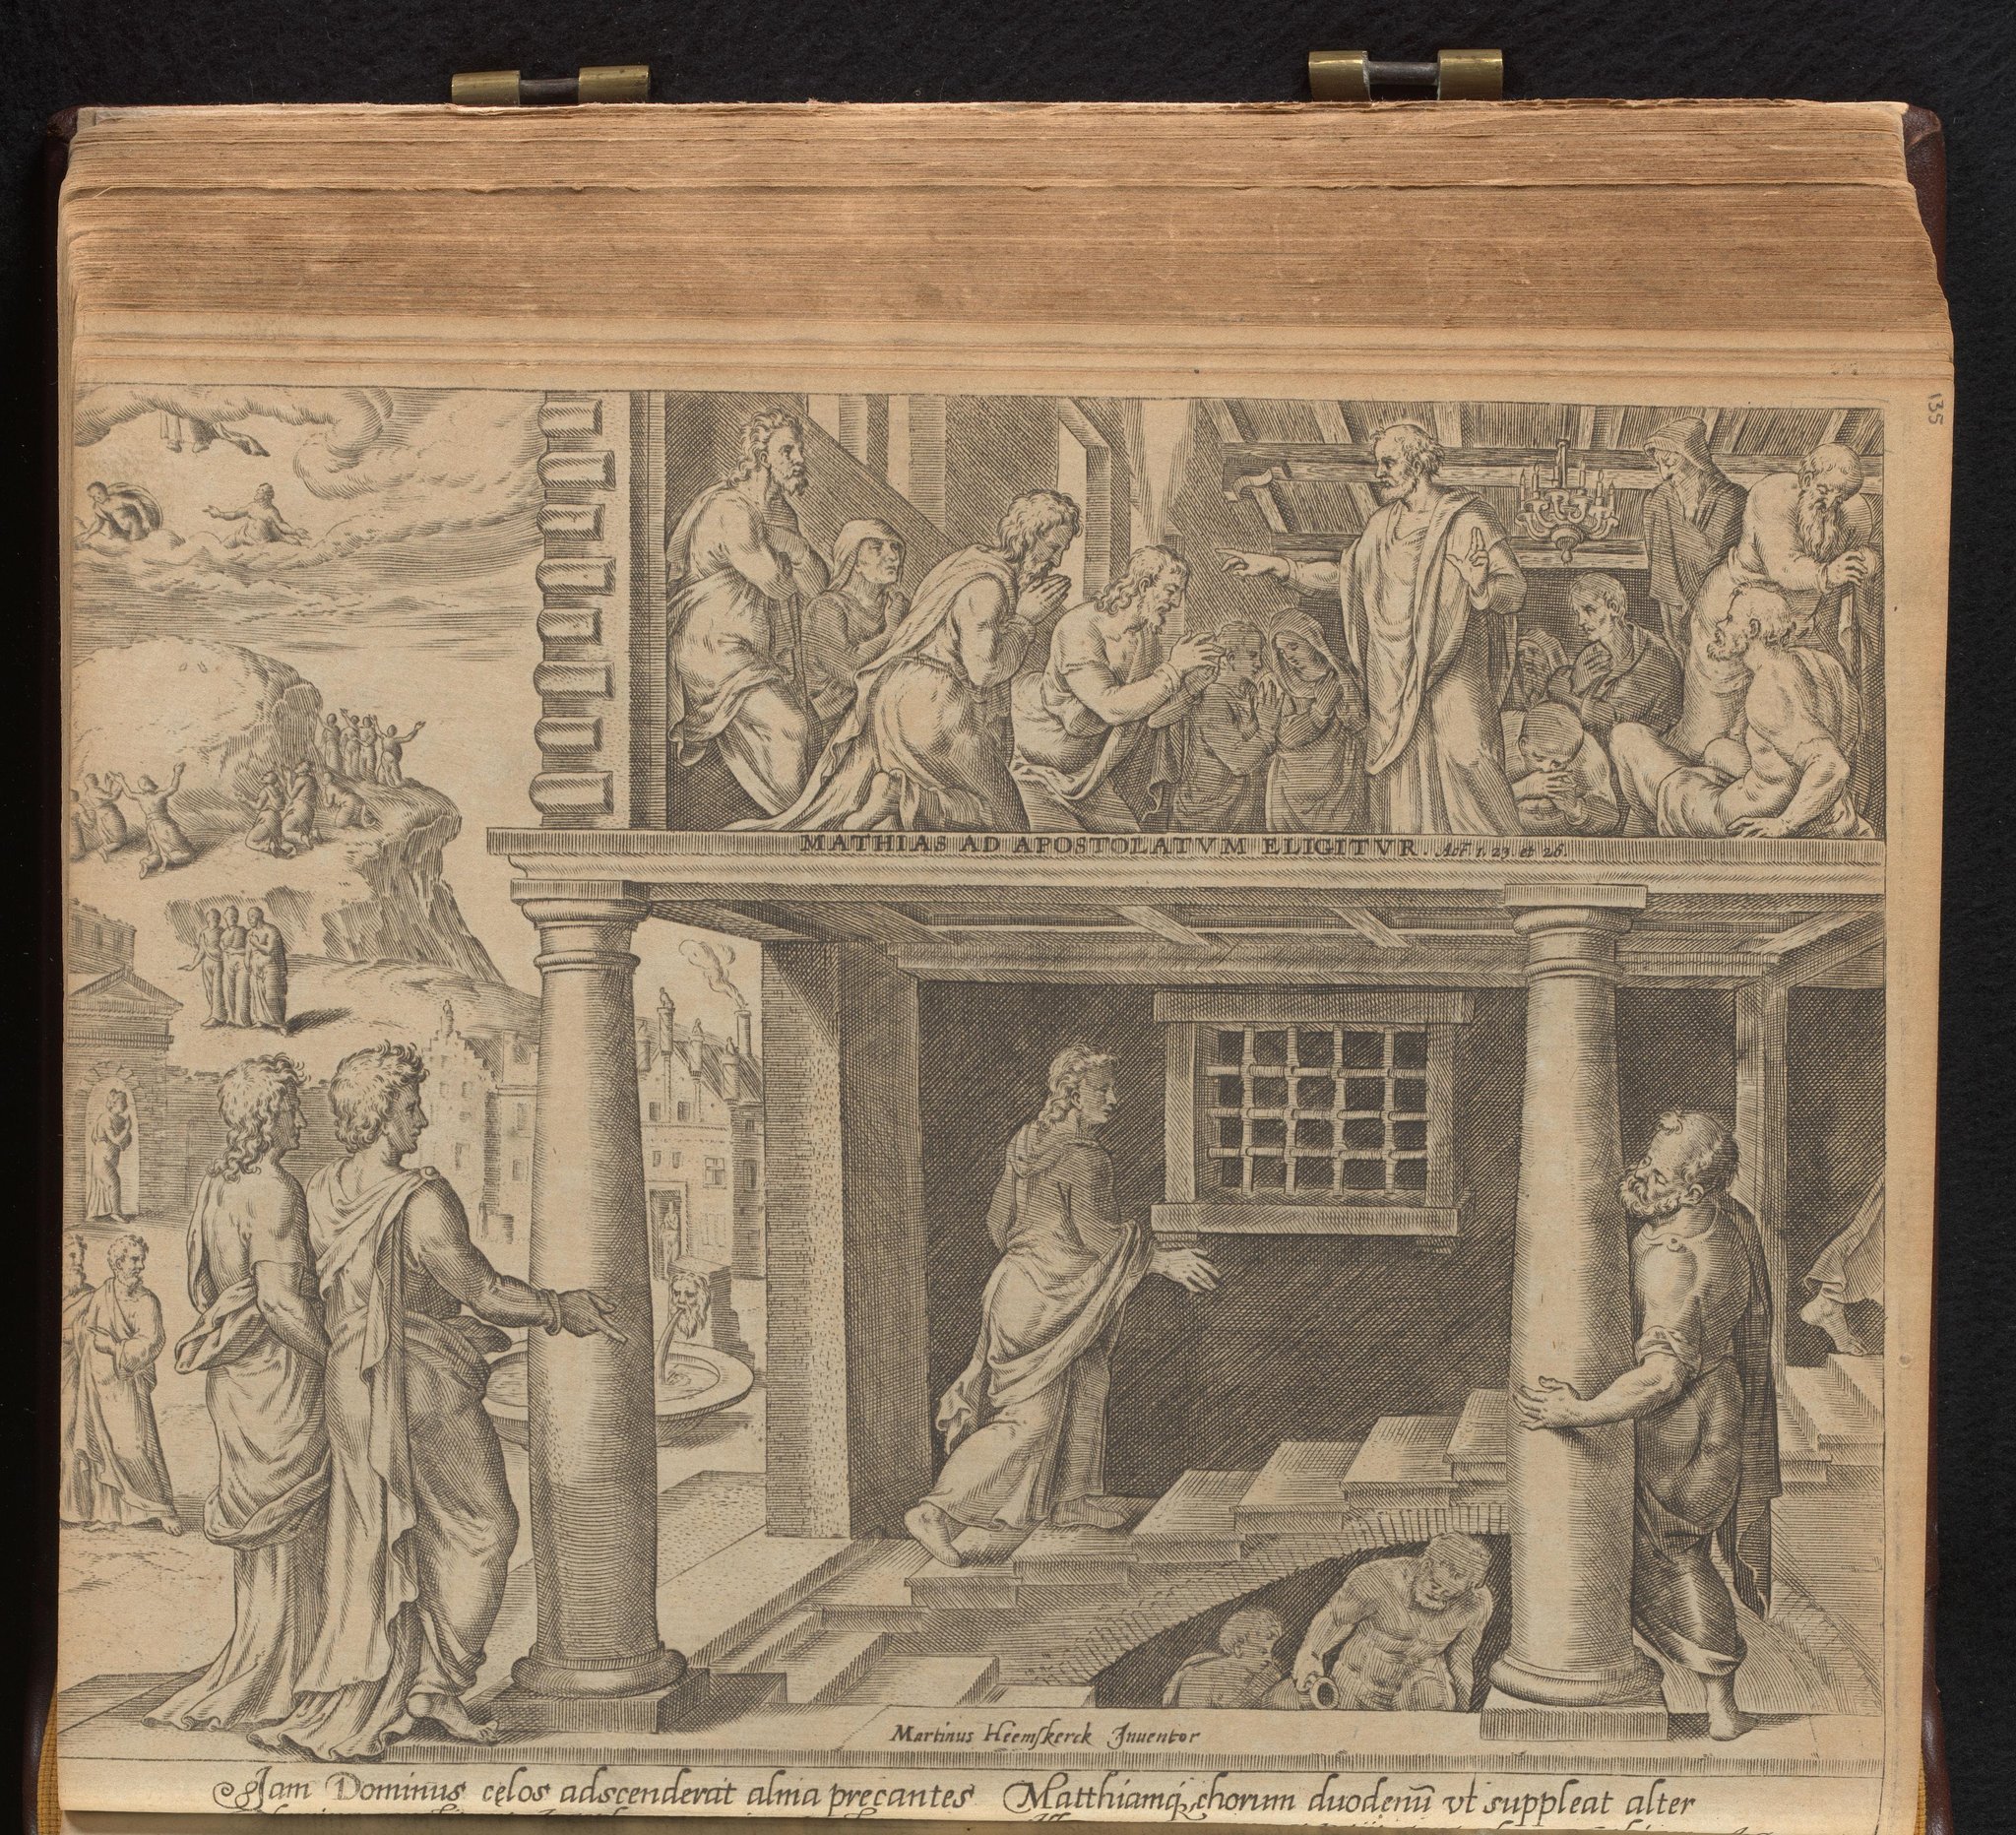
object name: titelprent, frontispice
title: Acta Apostolorum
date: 1575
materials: paper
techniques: engraving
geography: antwerp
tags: the ascension (christ surrounded by radiant light or in a mandorla), peter, in the midst of the disciples, proposes choosing an apostle to take judas' place (acts 1:15-26)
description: Prent maakt deel uit van een prentbijbel.